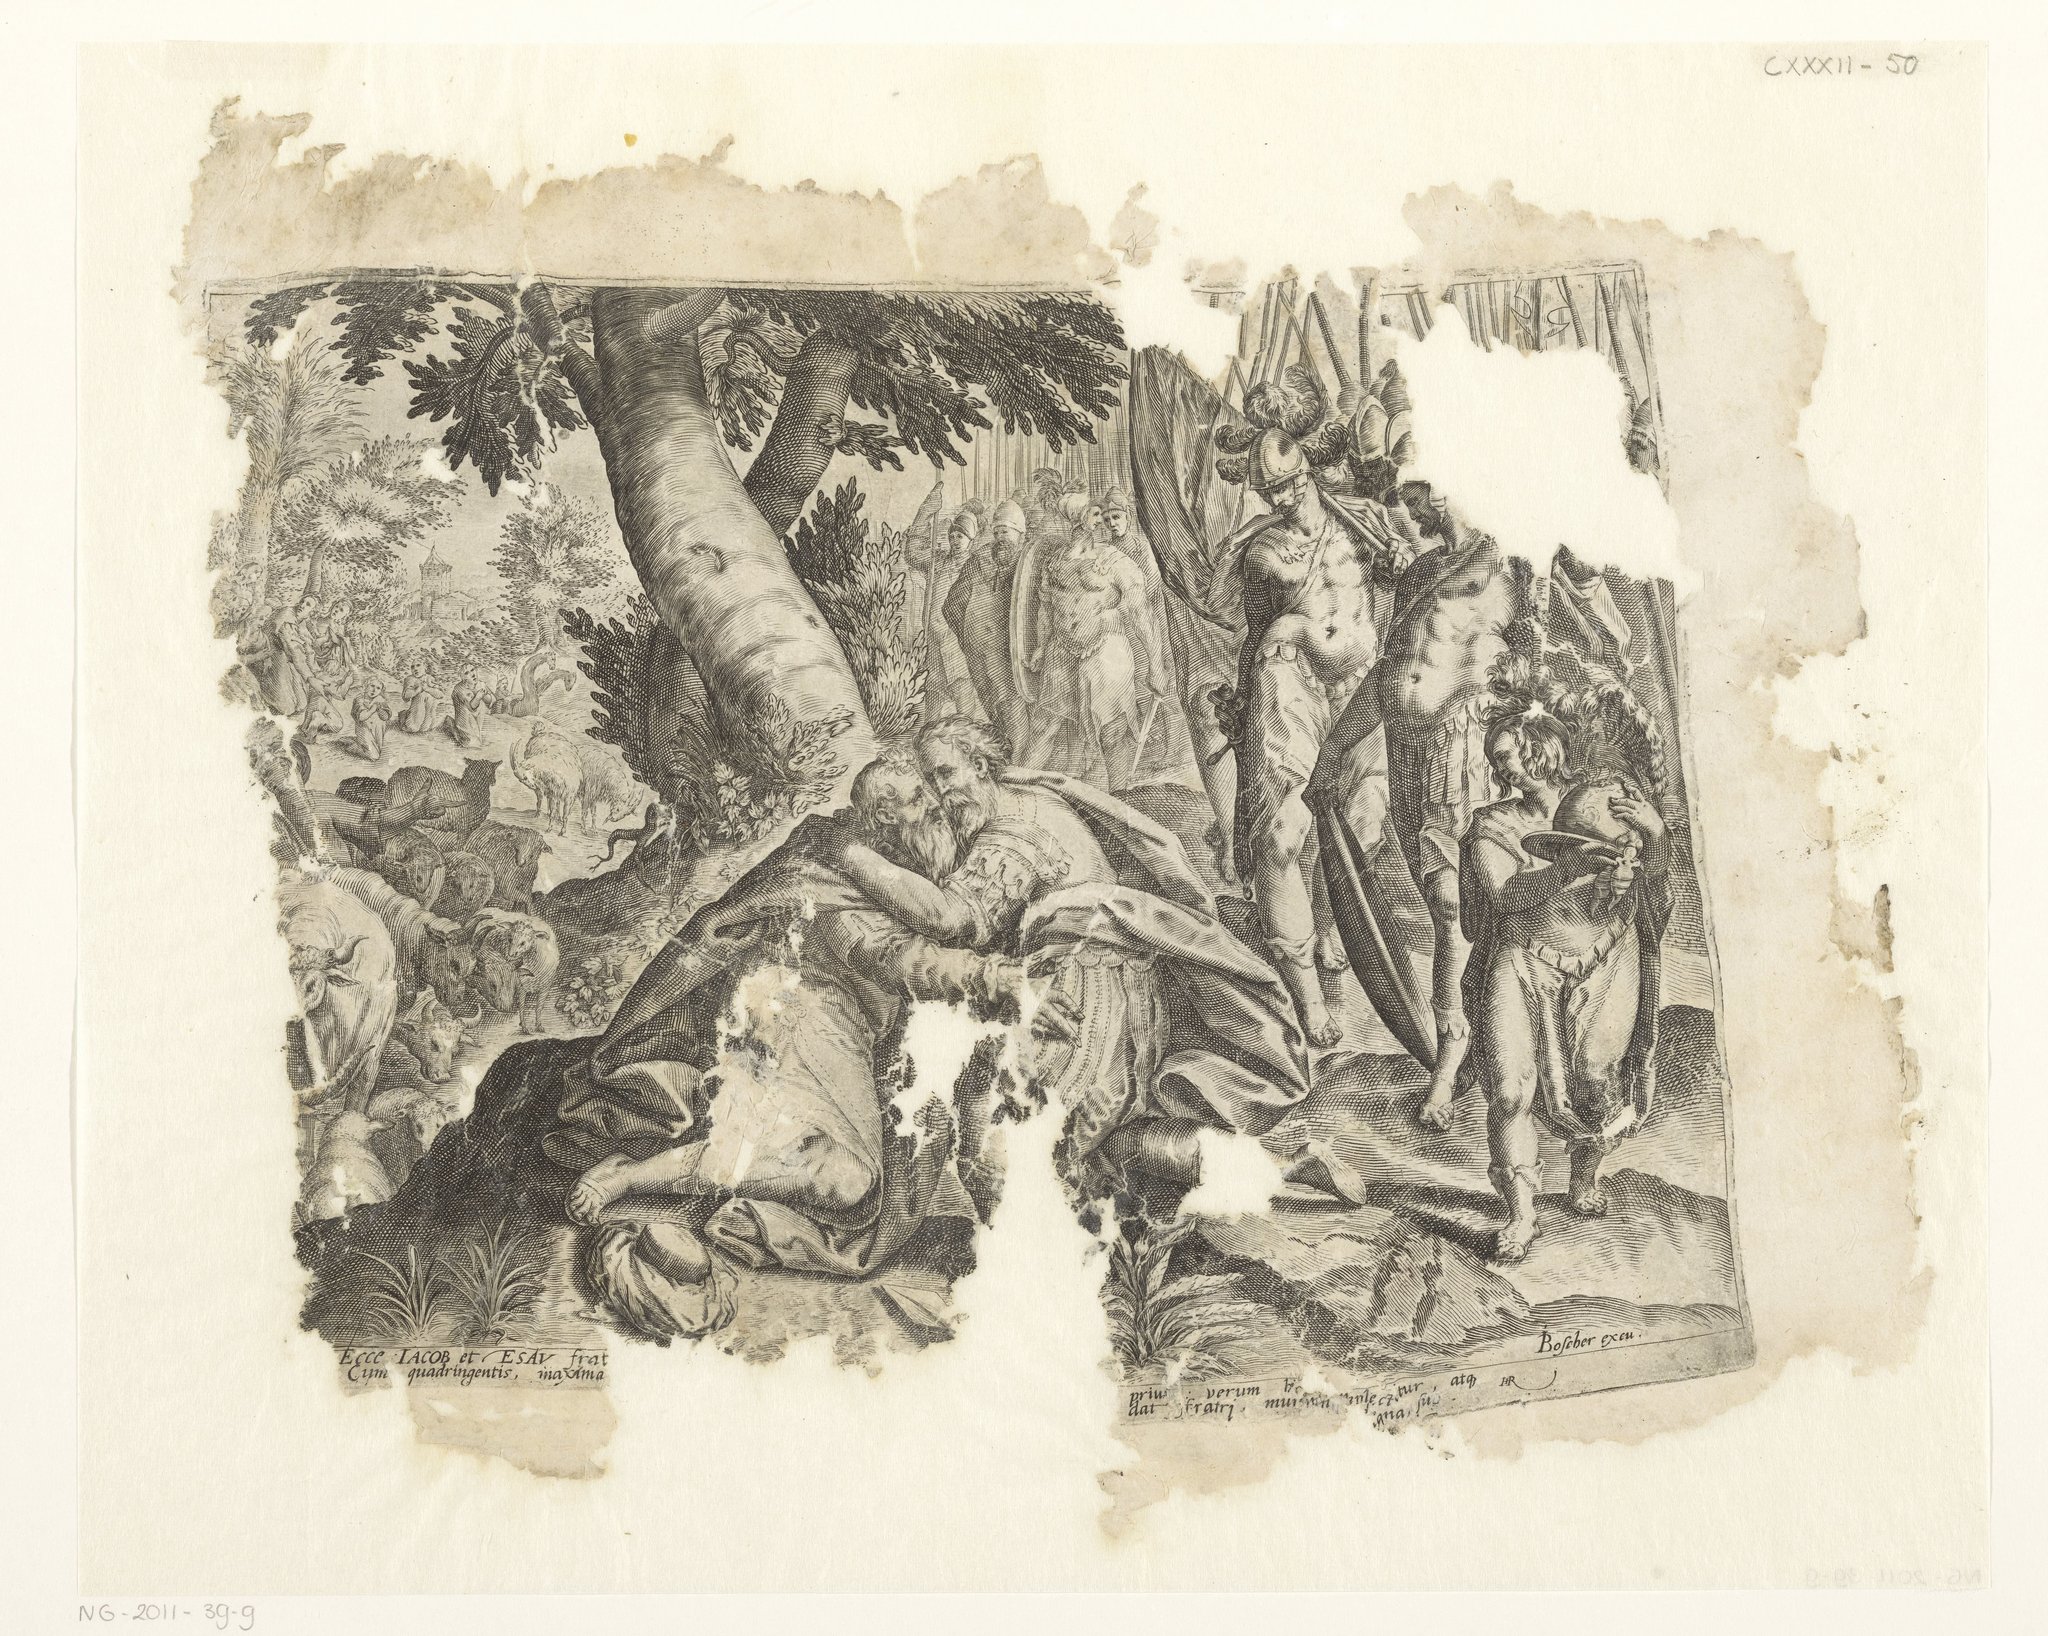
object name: print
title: Verzoening van Jakob en Esau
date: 1580-1596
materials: paper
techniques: engraving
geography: northern netherlands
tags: the meeting between esau and jacob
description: Tot dusverre was deze prent alleen bekend in een latere editie met het adres van C.J. Visscher in het door hem uitgegeven Theatrum Biblicum uit 1643, zie RP-P-1976-30-39. De prenten in de Nova Zembla collectie zijn tijdens een expeditie van Willem Barendsz en Jacob van Heemskerk in 1596-1597 noodgedwongen in het winterkamp, het ‘Behouden Huis’, op het eiland achtergelaten. De prenten waren in één of meerdere stapels als handelswaar meegenomen vanuit Amsterdam. Bijna drie eeuwen later, in 1871, keerde de Noor Elling Carlsen terug naar Nova Zembla en vond daar de restanten van het ‘Behouden Huis, inclusief een groot deel van de inventaris. Een deel van de prenten, in de vorm van aaneengekoekte kluiten, werd toen ook teruggevonden. De papierkluiten waren soms op meerdere plekken gebroken. Tussen 1975-1979 zijn de prenten van elkaar gescheiden. Dit leverde in totaal ca. 1000 fragmenten van ca. 400 afdrukken van ca. 150 verschillende prenten op. Voor zover mogelijk zijn de fragmenten samengevoegd en zijn de prenten gereconstrueerd.